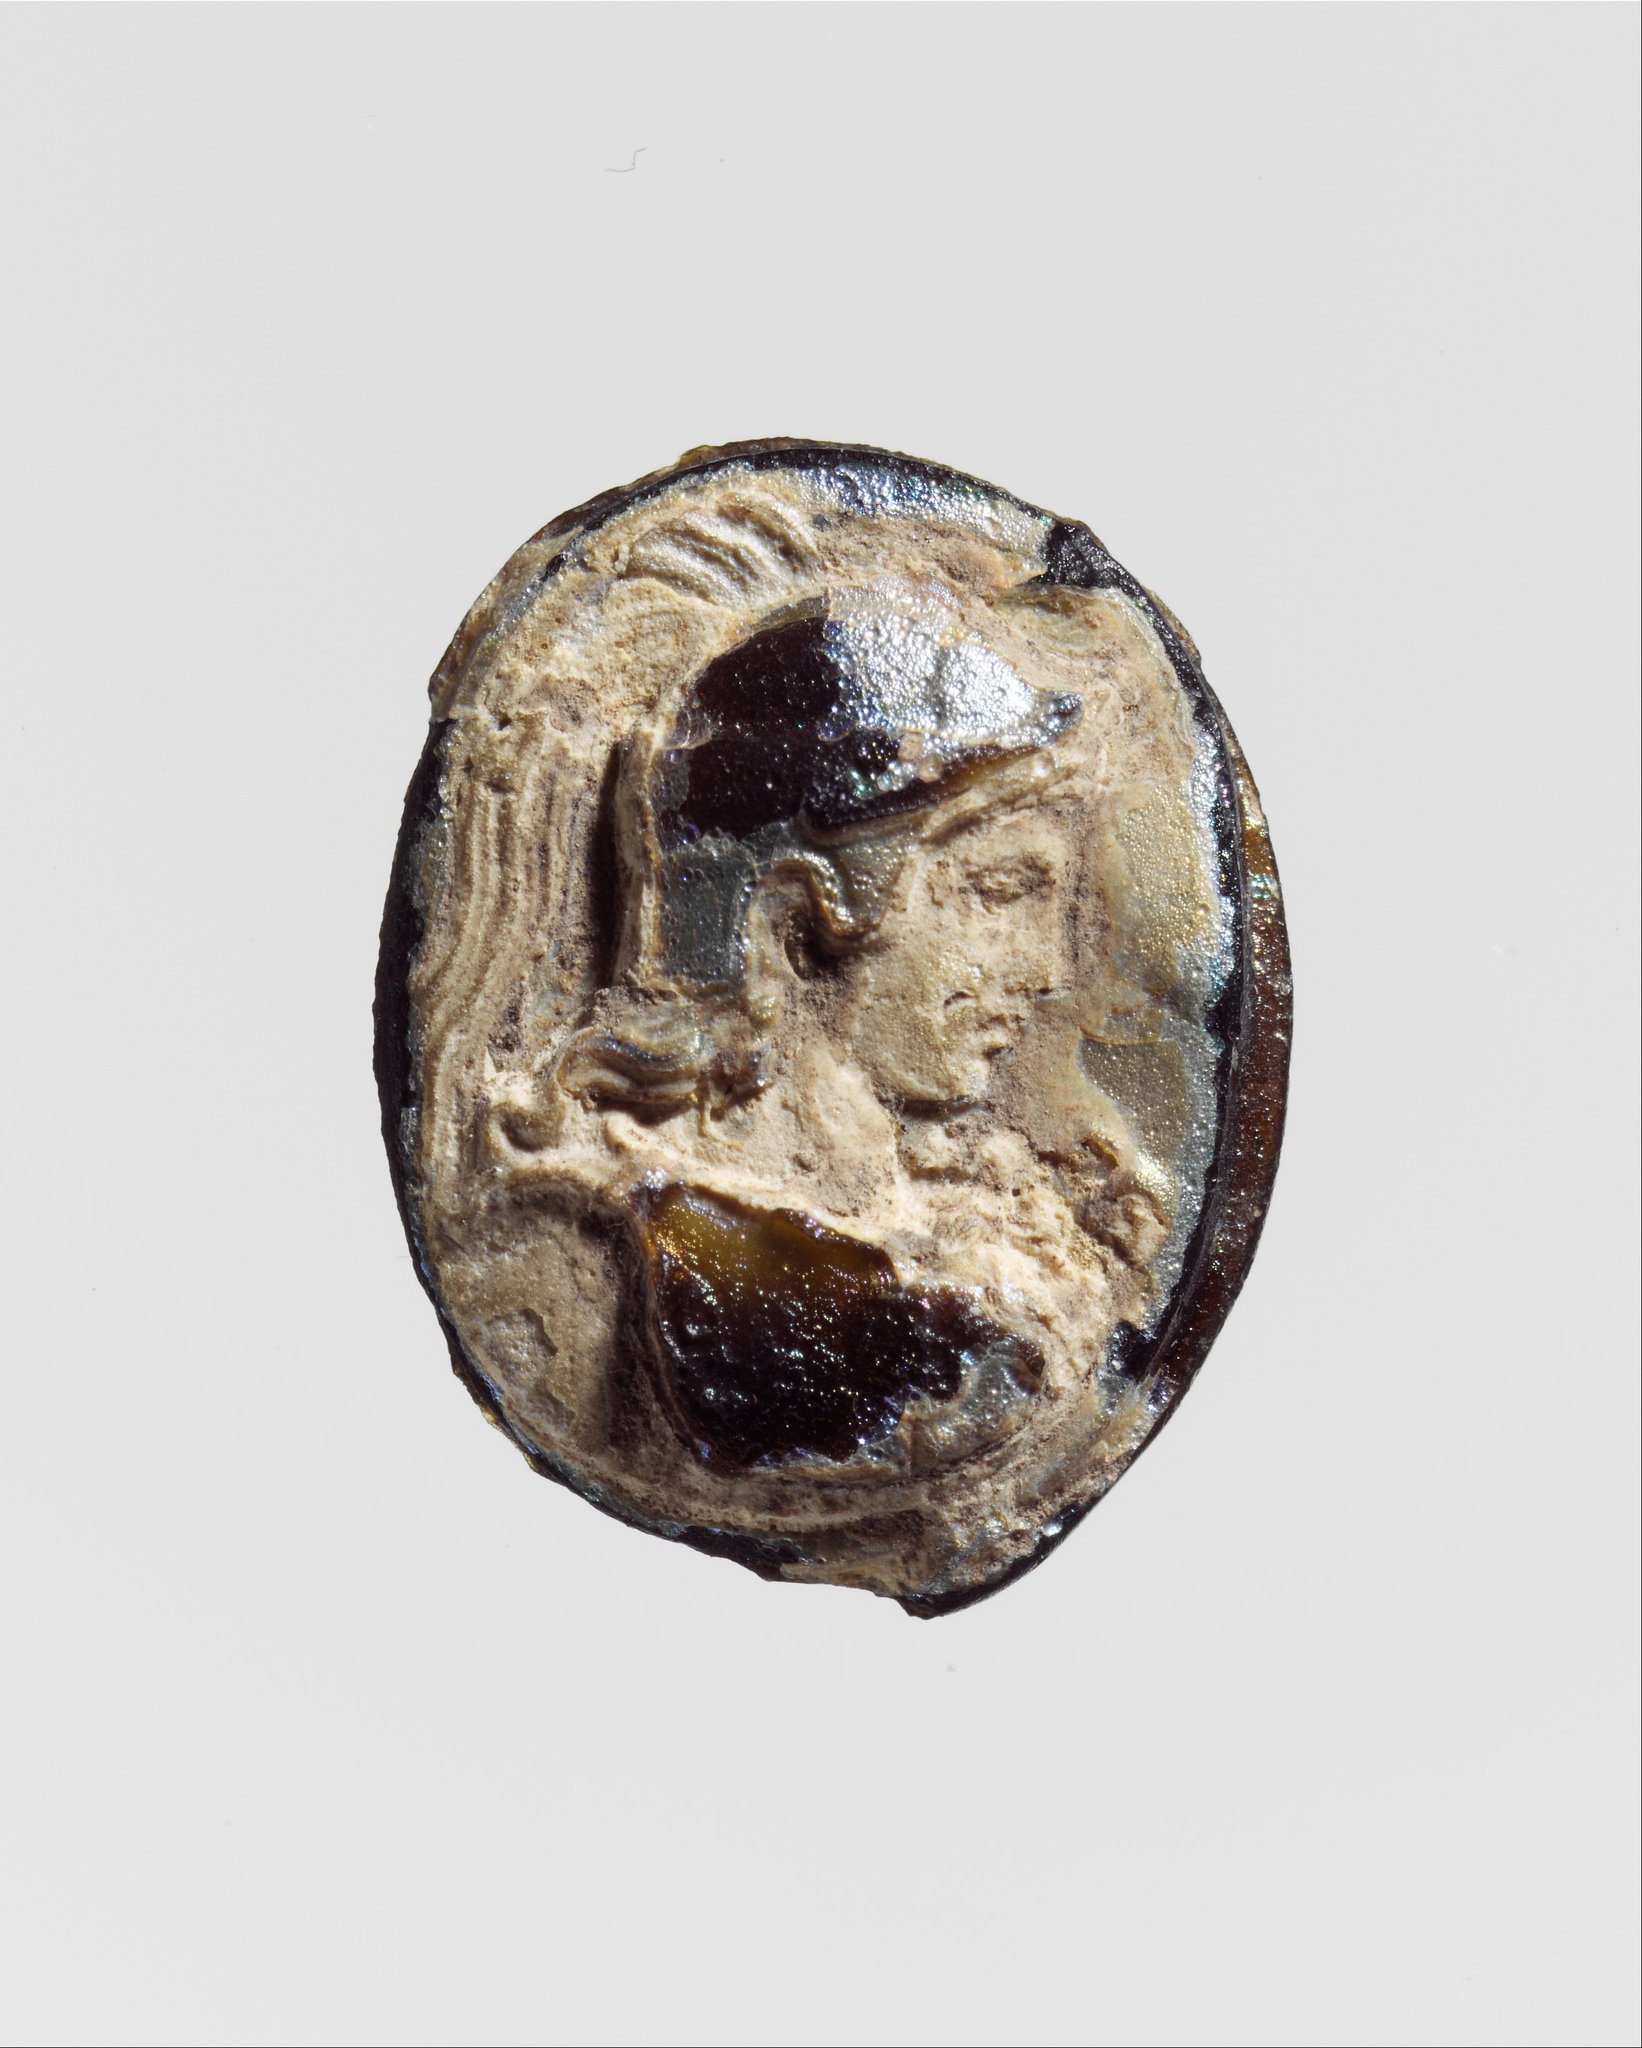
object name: cameo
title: Glass cameo: bust of Athena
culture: roman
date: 100 BCE-300 CE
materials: glass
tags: profiles,athena